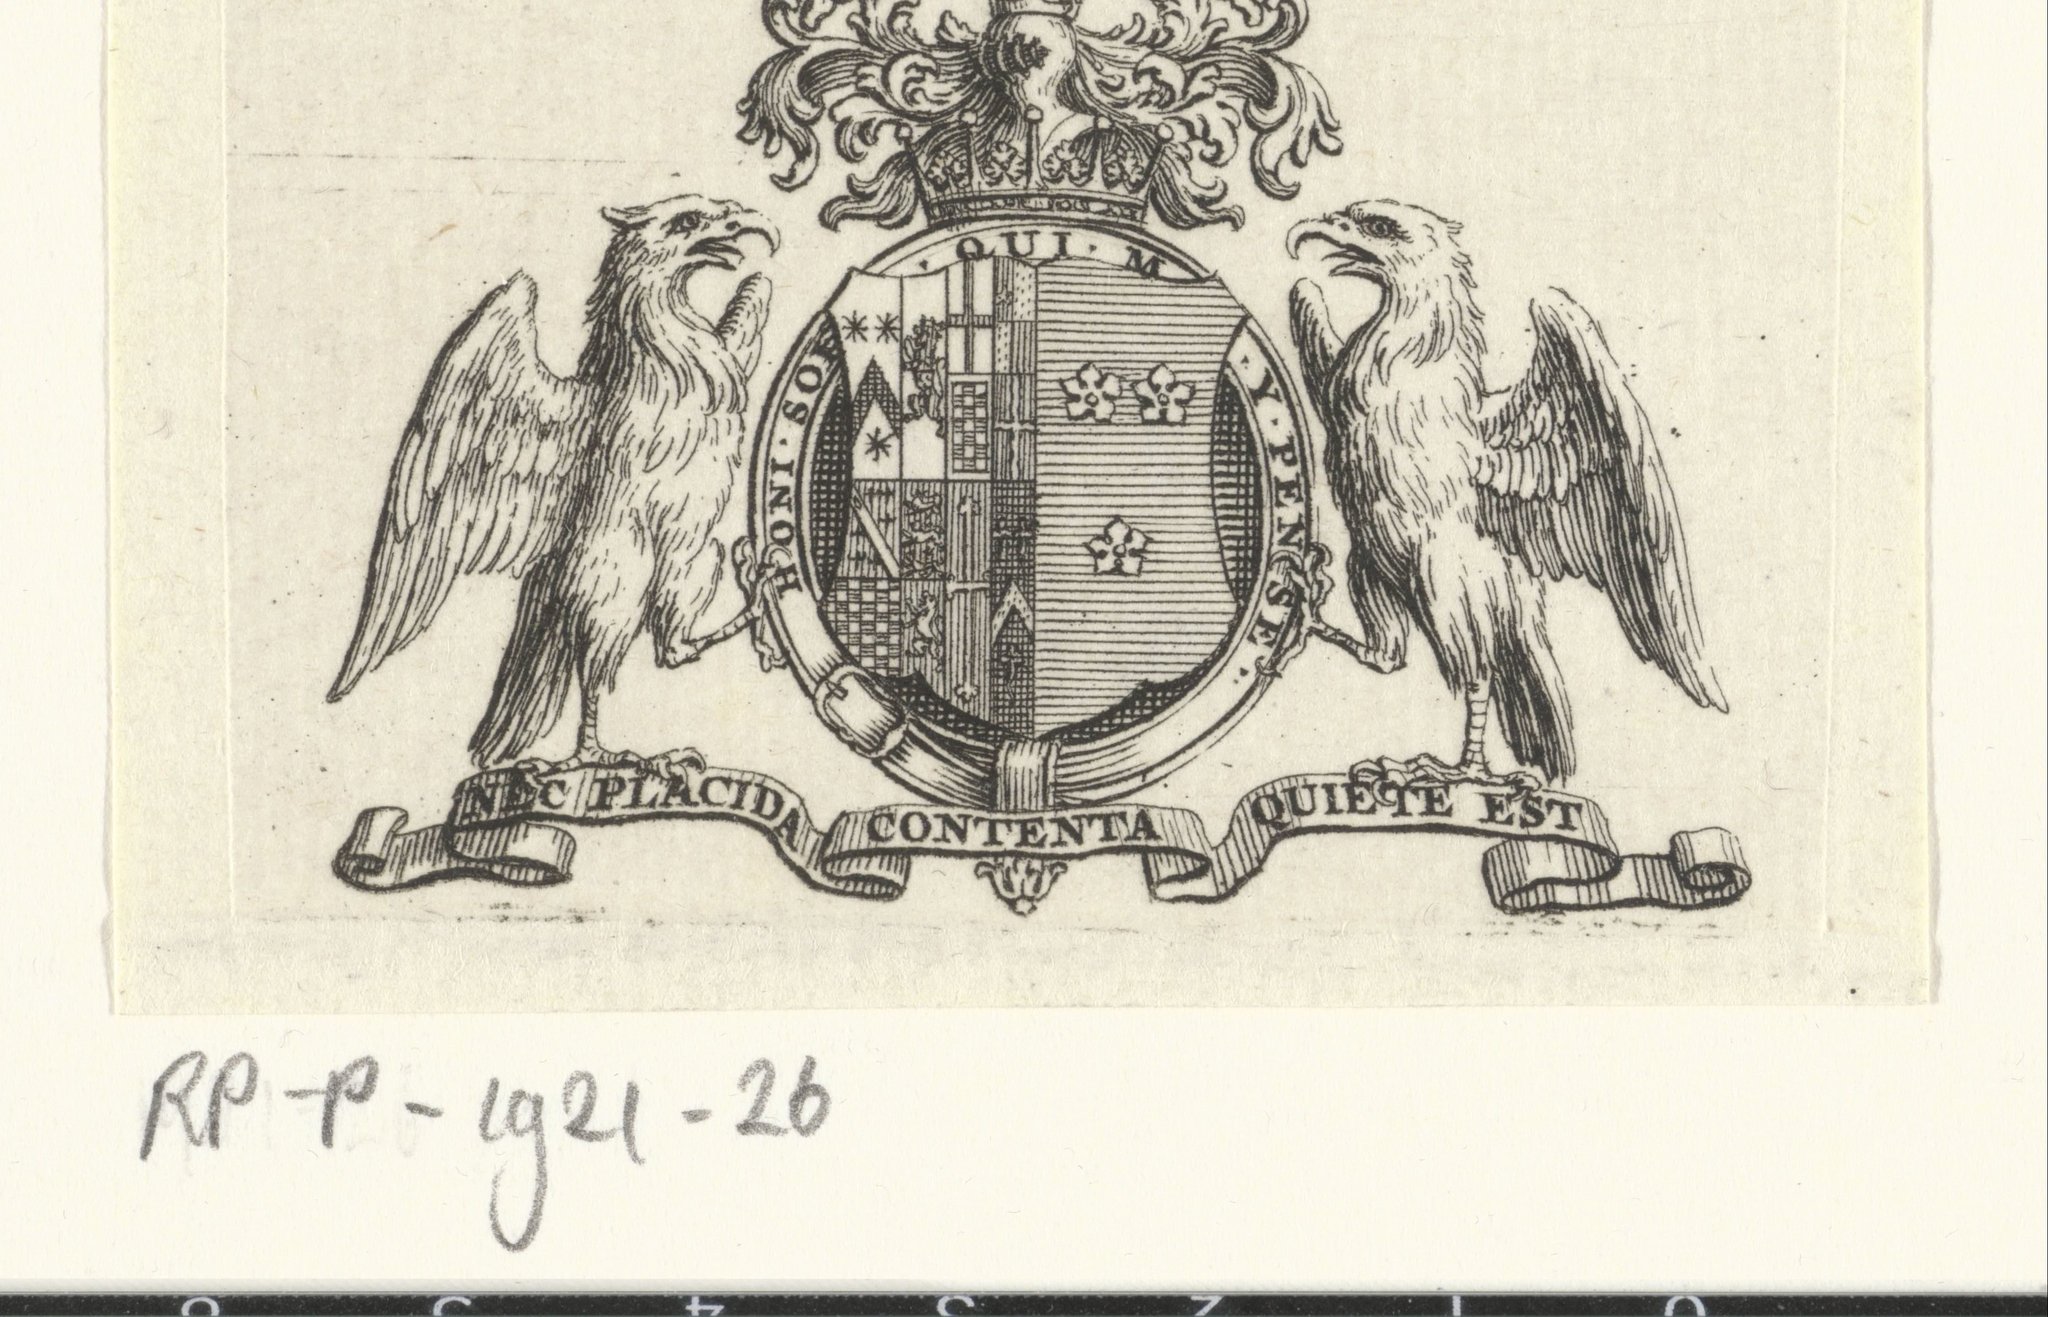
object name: print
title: Wapenschild geflankeerd door twee adelaars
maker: Anonymous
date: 1683-1783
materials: paper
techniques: engraving, etching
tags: coat of arms (as symbol of the state, etc.), predatory birds: eagle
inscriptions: collector's mark: Lugt 2233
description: Wapenschild met het devies van de Orde van de Kousenband geflankeerd door twee adelaars. Daaronder het devies: Nec Placida Contenta Quiete est.